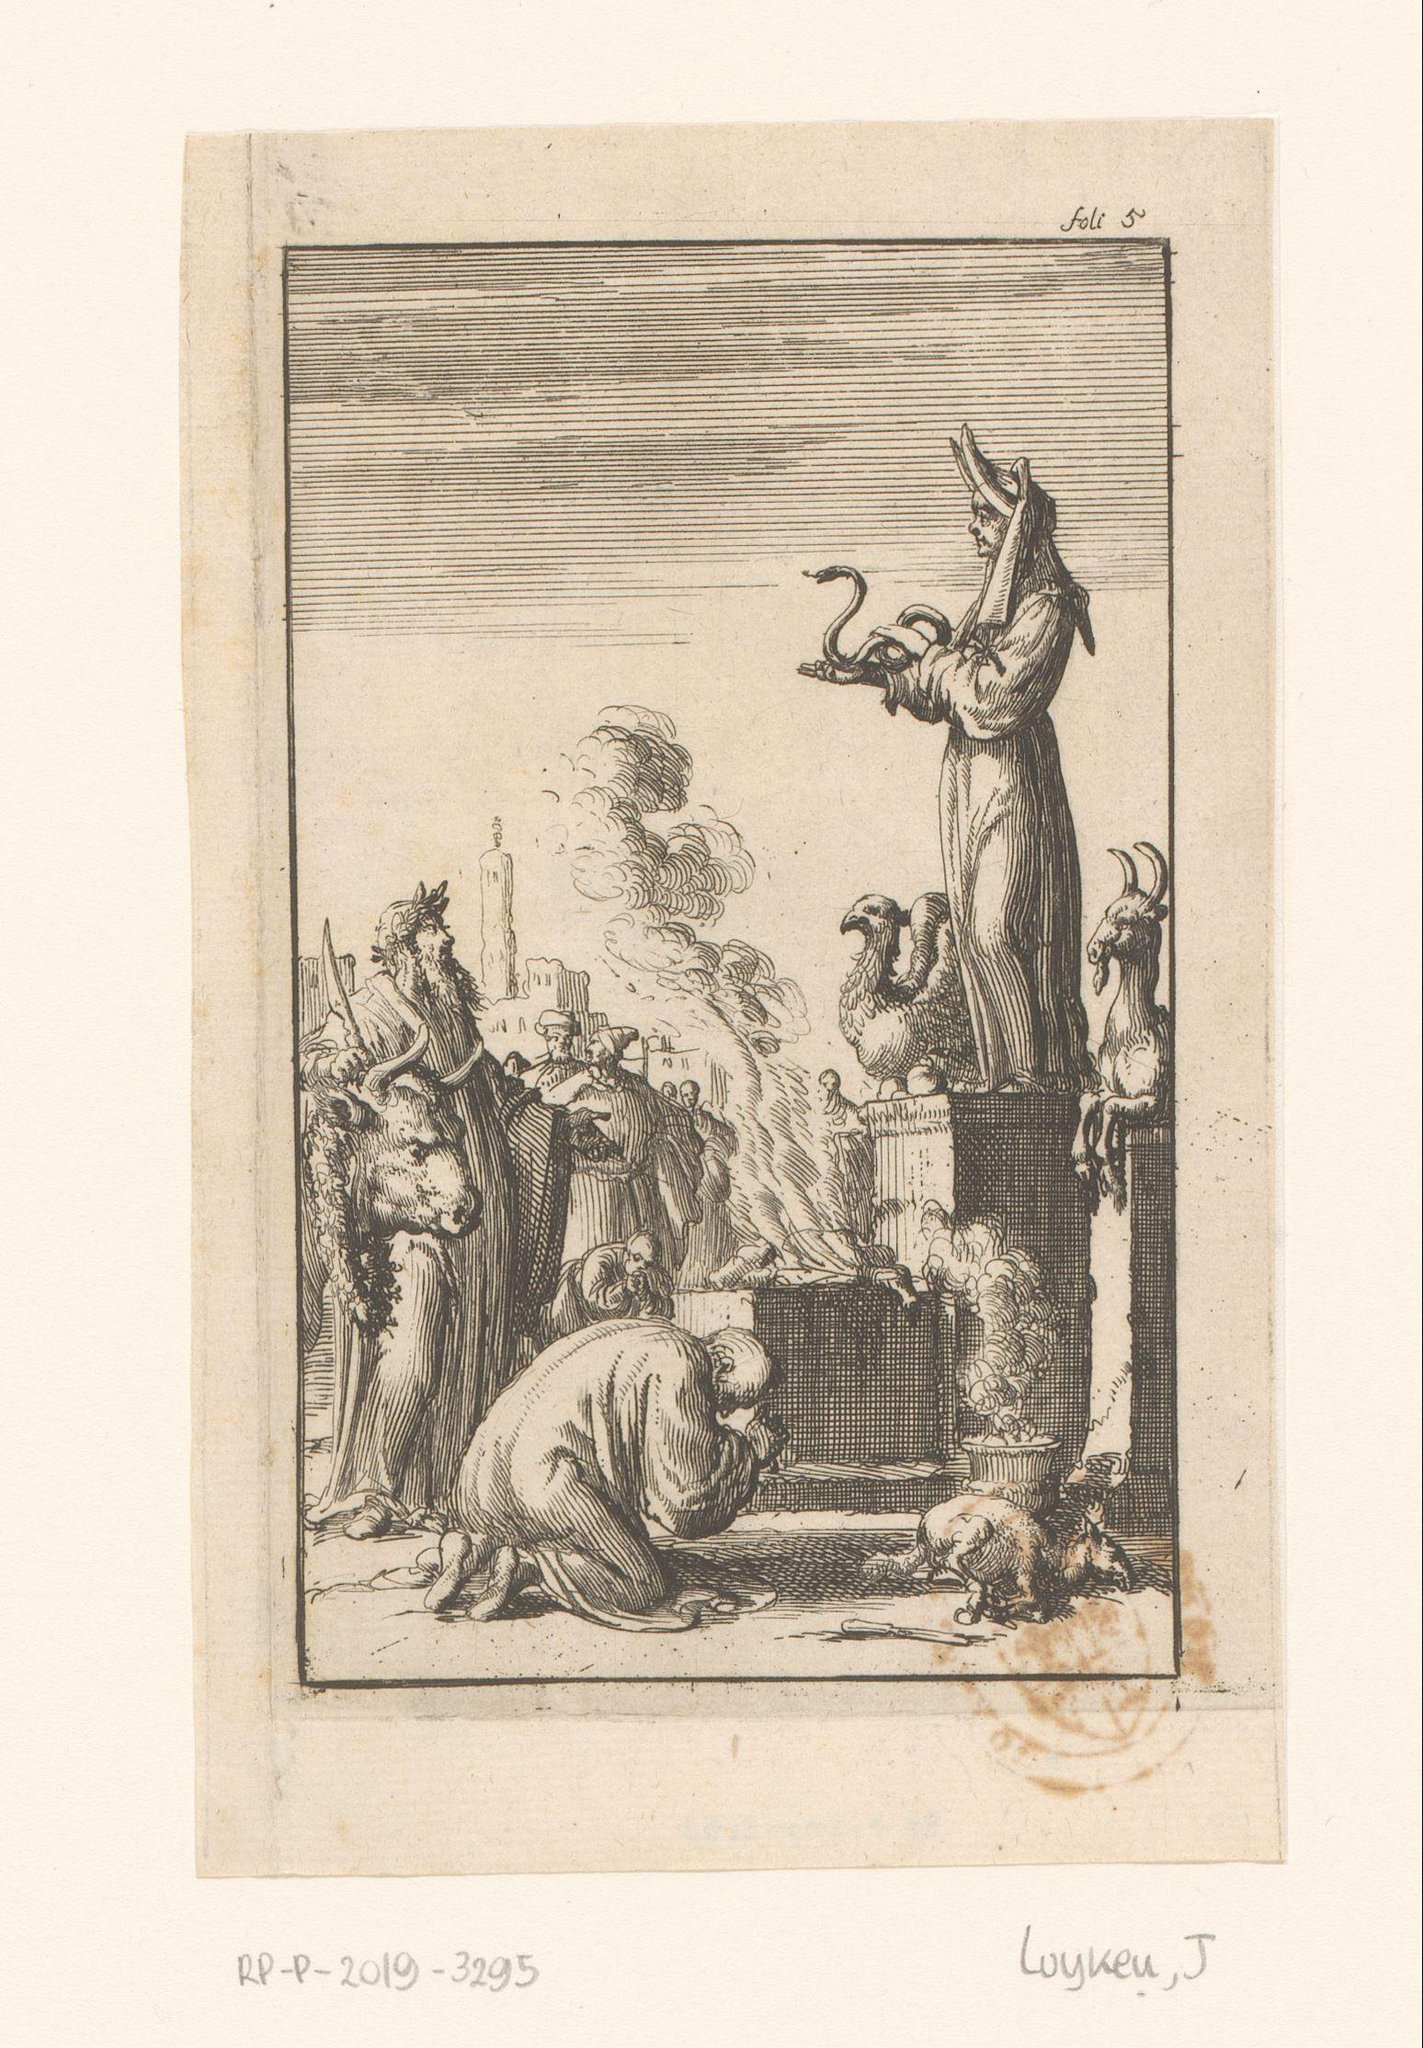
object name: book illustration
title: Gij zult geen afgoden vereren: het eerste Gebod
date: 1685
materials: paper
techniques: etching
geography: amsterdam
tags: sacrifice ~ non-christian religions, the ten commandments (exodus 20:3-17), 'you shall have no other gods' ~ separate representation of the first of the ten commandments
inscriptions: collector's mark: Lugt 240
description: Prent uit: Hondorffius, Andreas. De tien geboden des Heeren (...). Amsterdam: Jan Bouman, 1685.